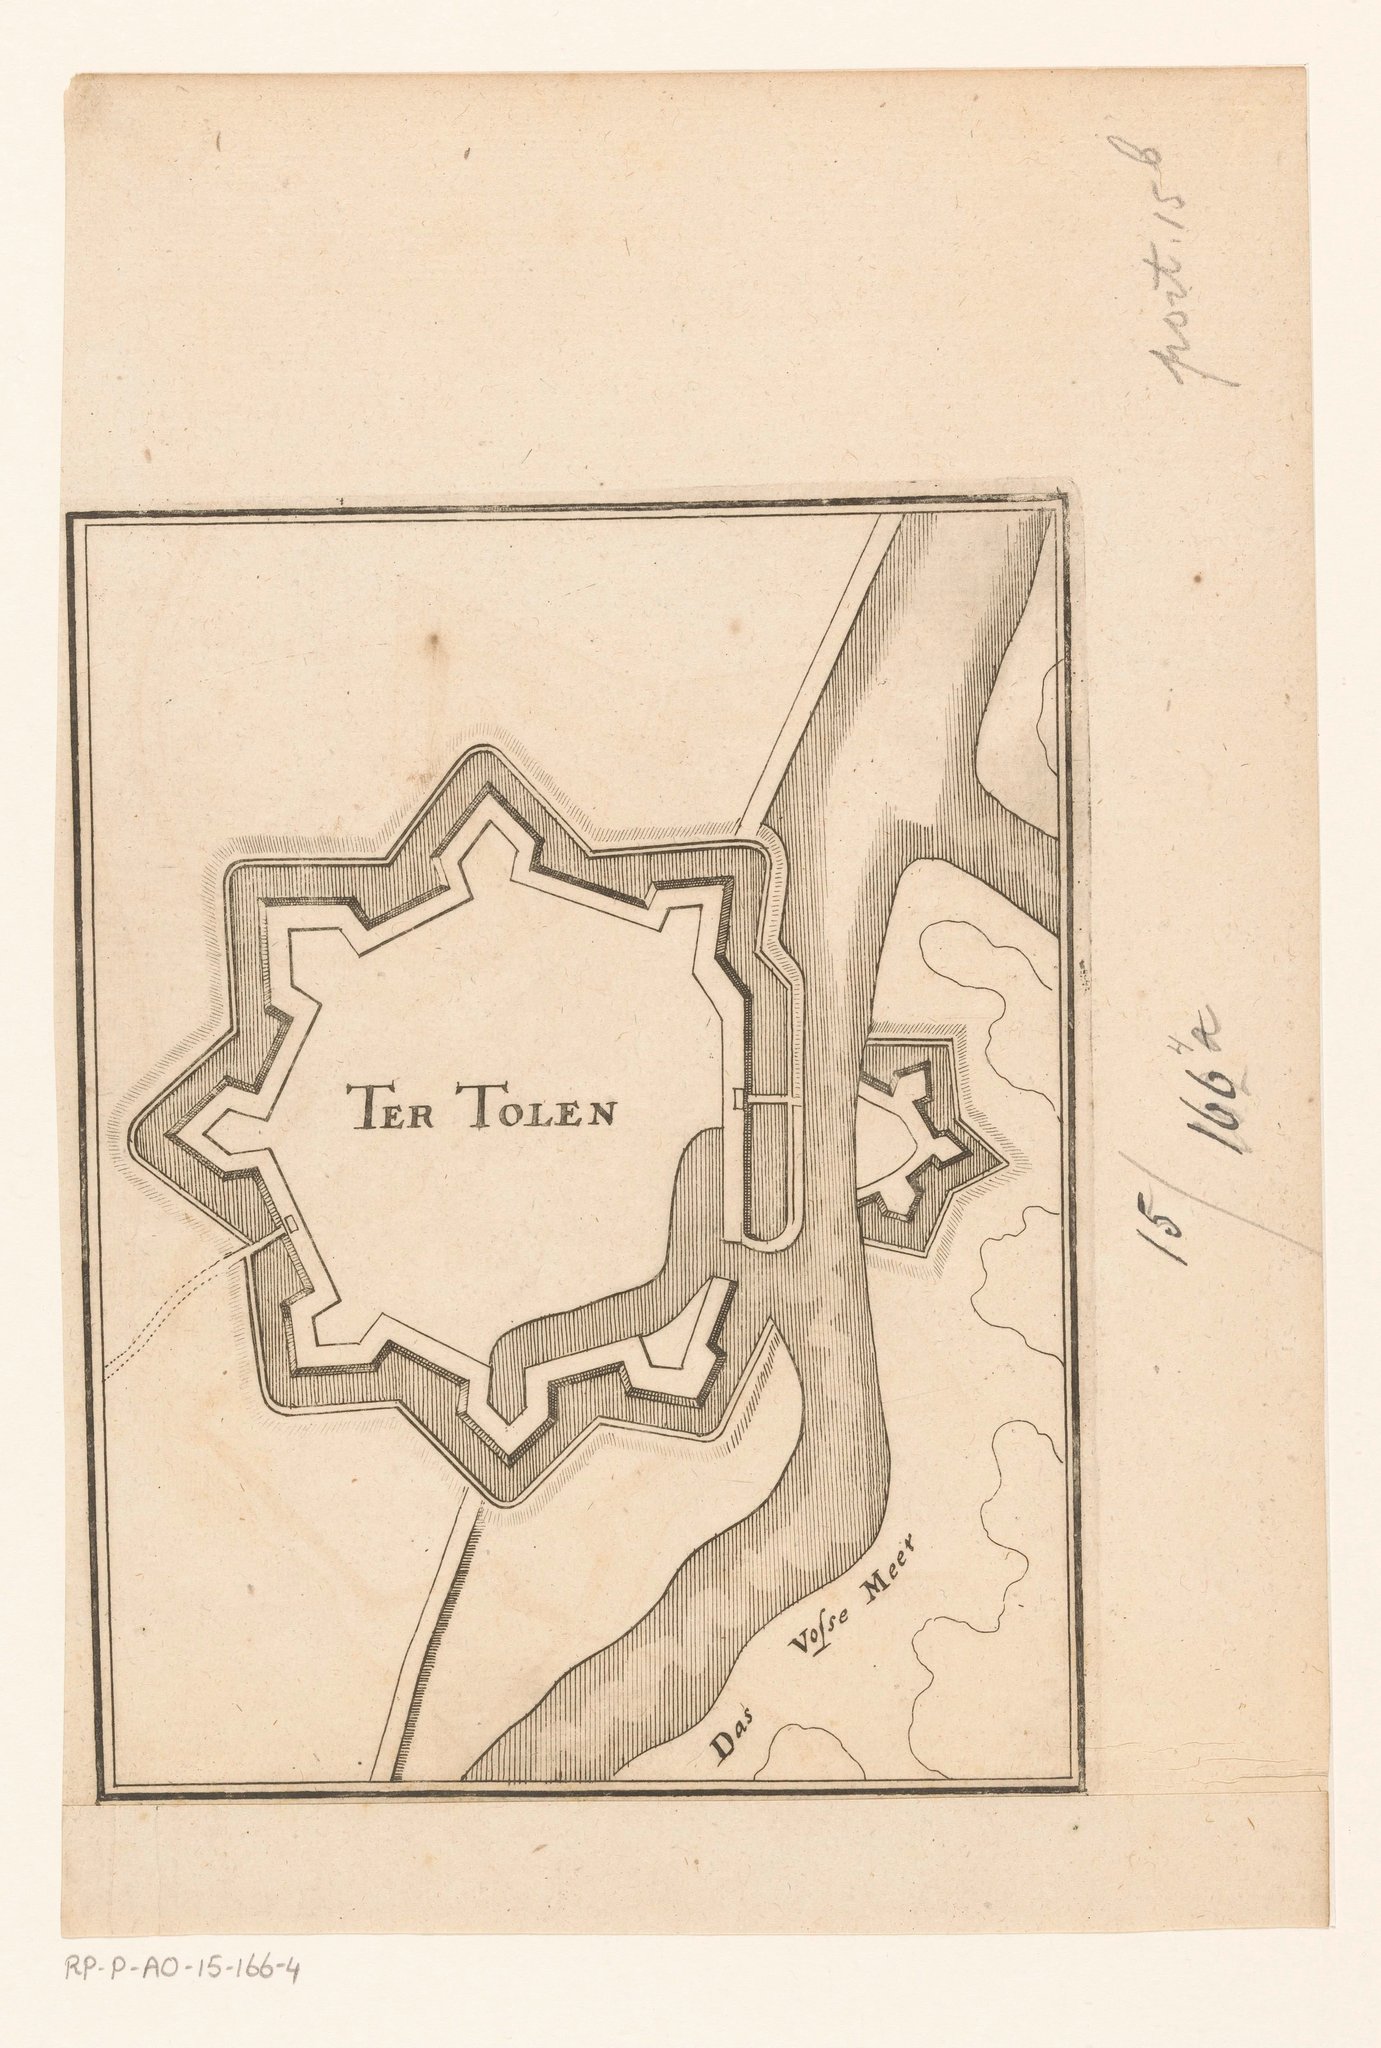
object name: print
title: Ter Tolen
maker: caspar merian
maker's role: print maker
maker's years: 1627-1689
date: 1654-1700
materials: paper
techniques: etching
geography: frankfurt am main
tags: fortified city, maps of cities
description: Prent gebruikt in: Zeiller, Martin. M.Z. Topographia Circuli Burgundici Oder Beschreibung une Eigentliche Abbildung der Vornehmsten Örter in dem Hochlöblichen Burgund- un Niderlandischen Crayse. Frankfurt am Main: Caspar Merian, 1654. Of in: Zeiller, Martin. M. Z. Topographia Germaniae-Inferioris vel Circuli-Burgundici, das ist Beschreibung (…). Frankfurt am Main: Caspar Merian, 1659. Of in een van de twee latere uitgaven van deze publicatie die, hoewel het jaar 1659 erin staat vermeld als jaar van uitgave, zijn uitgegeven in respectievelijk ca. 1670 en ca. 1700.